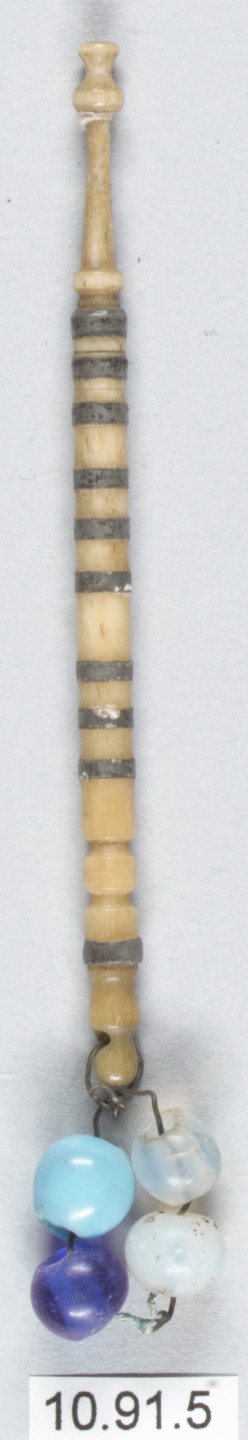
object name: bobbin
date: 1801-1900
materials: bone, metal